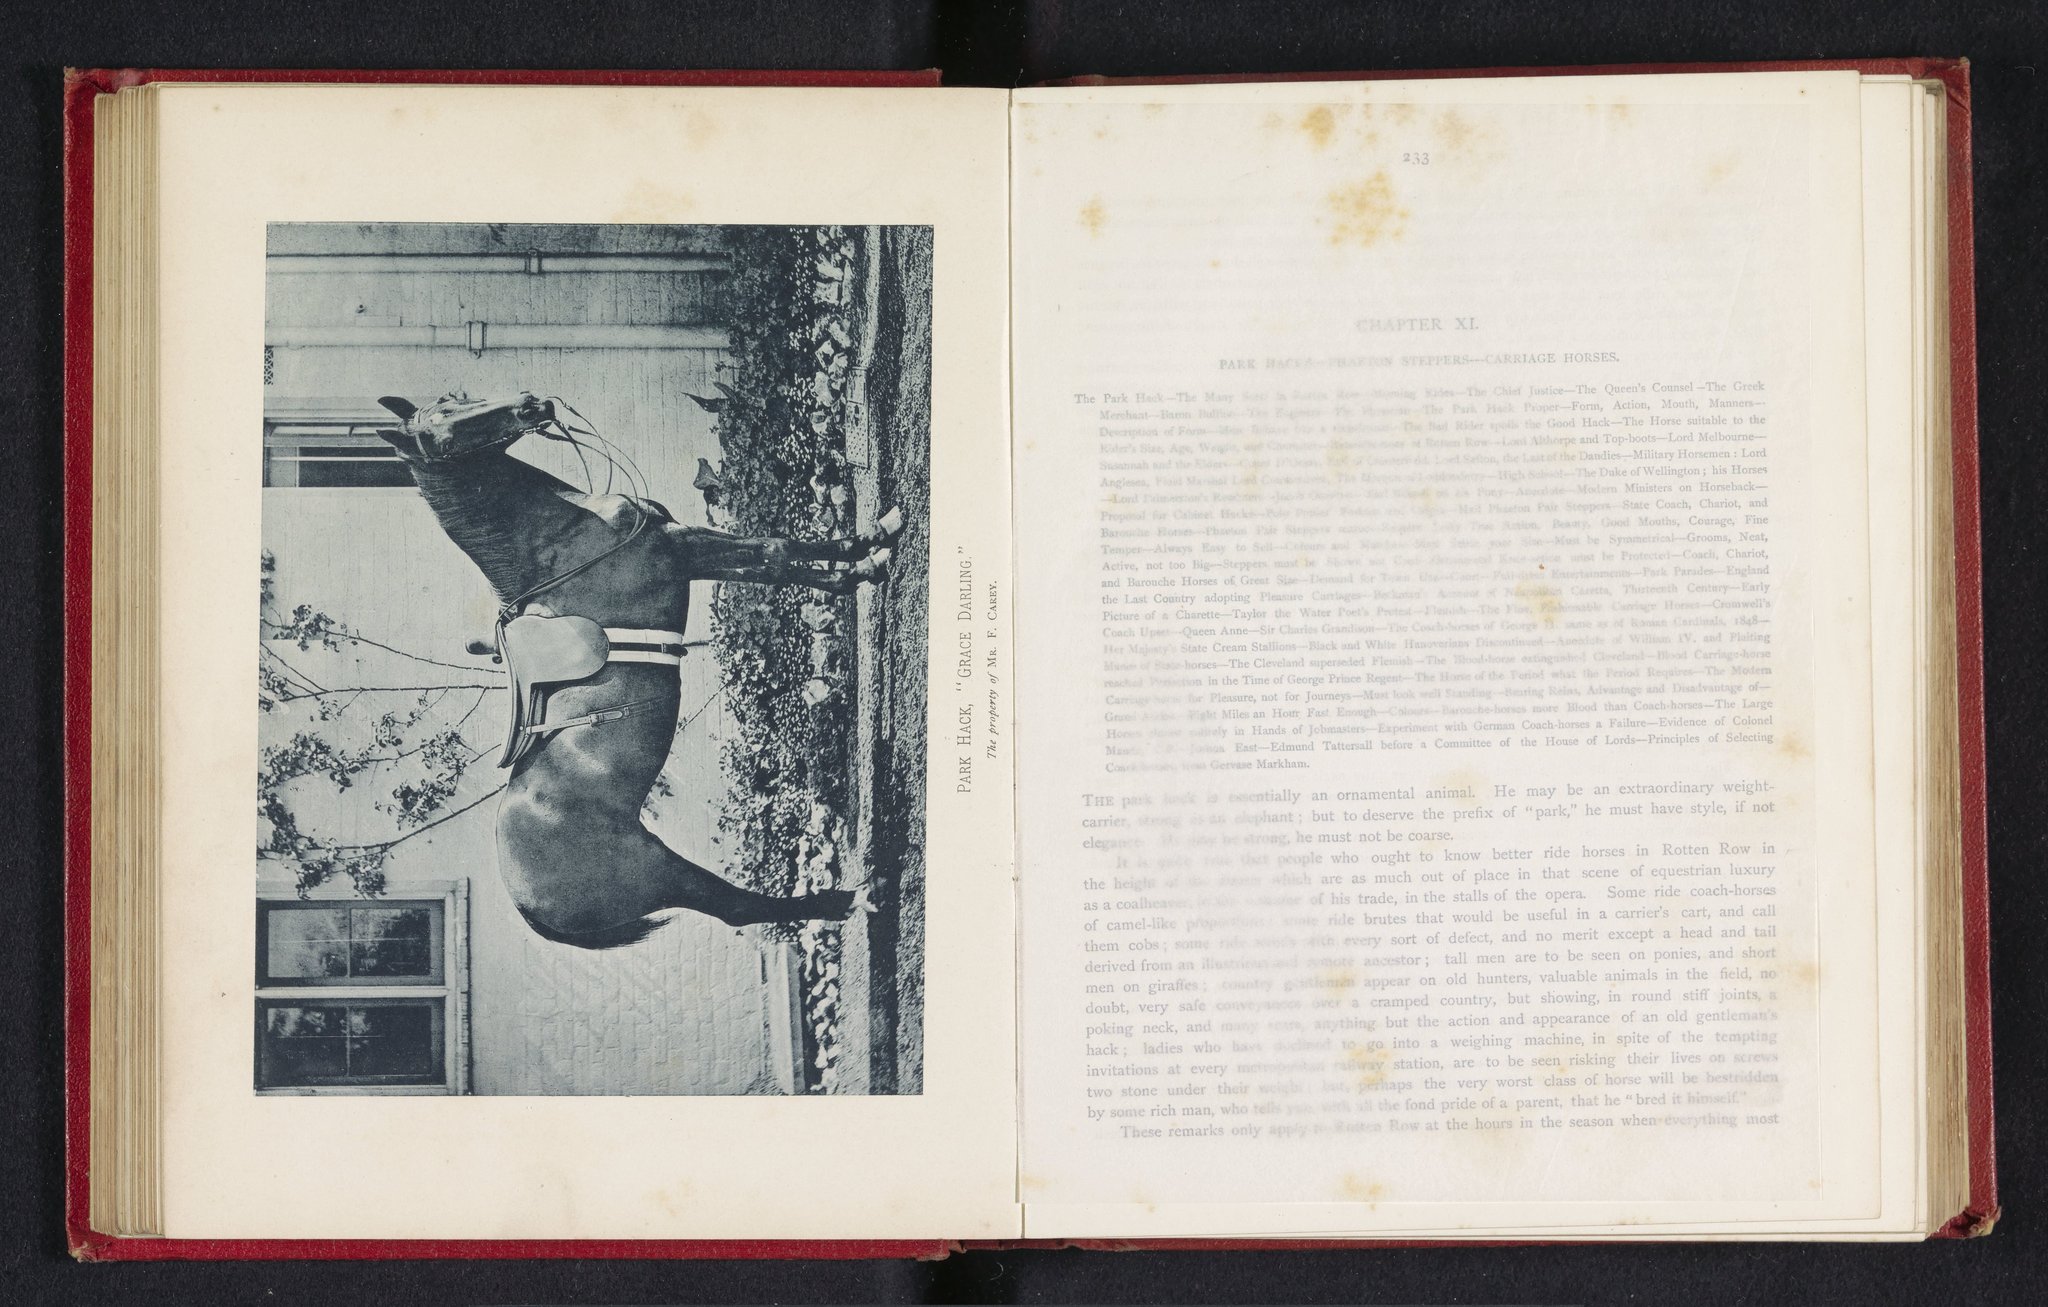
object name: photomechanical print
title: Park Hack, “Grace Darling”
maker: Anonymous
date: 1883-1893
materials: paper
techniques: photograph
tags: horse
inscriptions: inscription: ‘The property of Mr. F. Carey.’